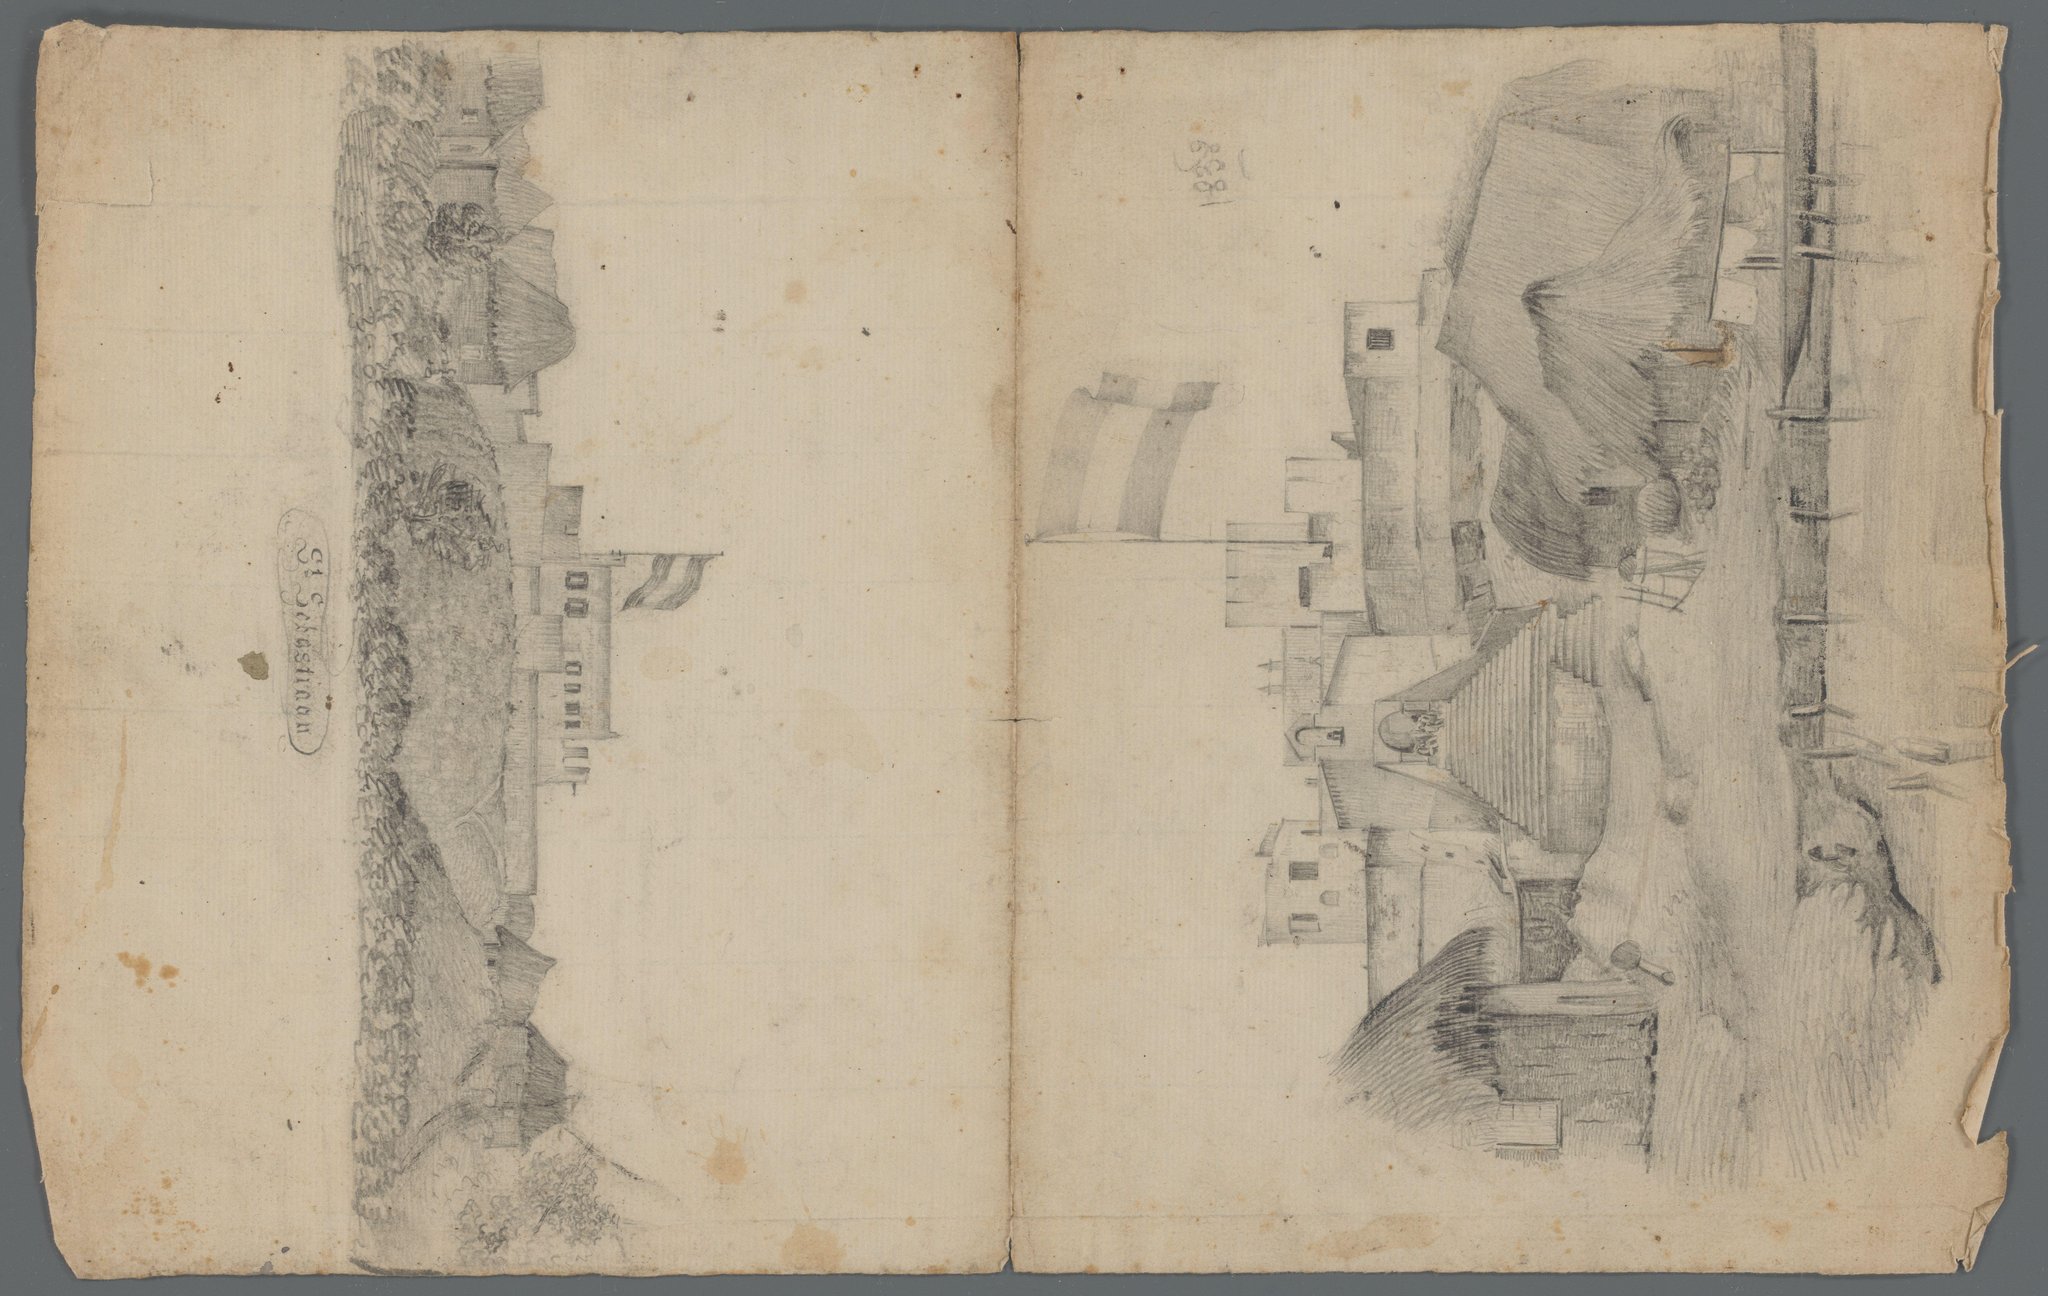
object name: drawing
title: Fort St. Sebastiaan in Ghana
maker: frederik lambertus geerling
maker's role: naval officer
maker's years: 1815-1894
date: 1838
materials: paper, pencil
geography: ghana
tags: fortress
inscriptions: date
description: Twee gezichten op het Nederlandse fort St. Sebastiaan in Shama, Ghana. Elk op een helft van het blad.